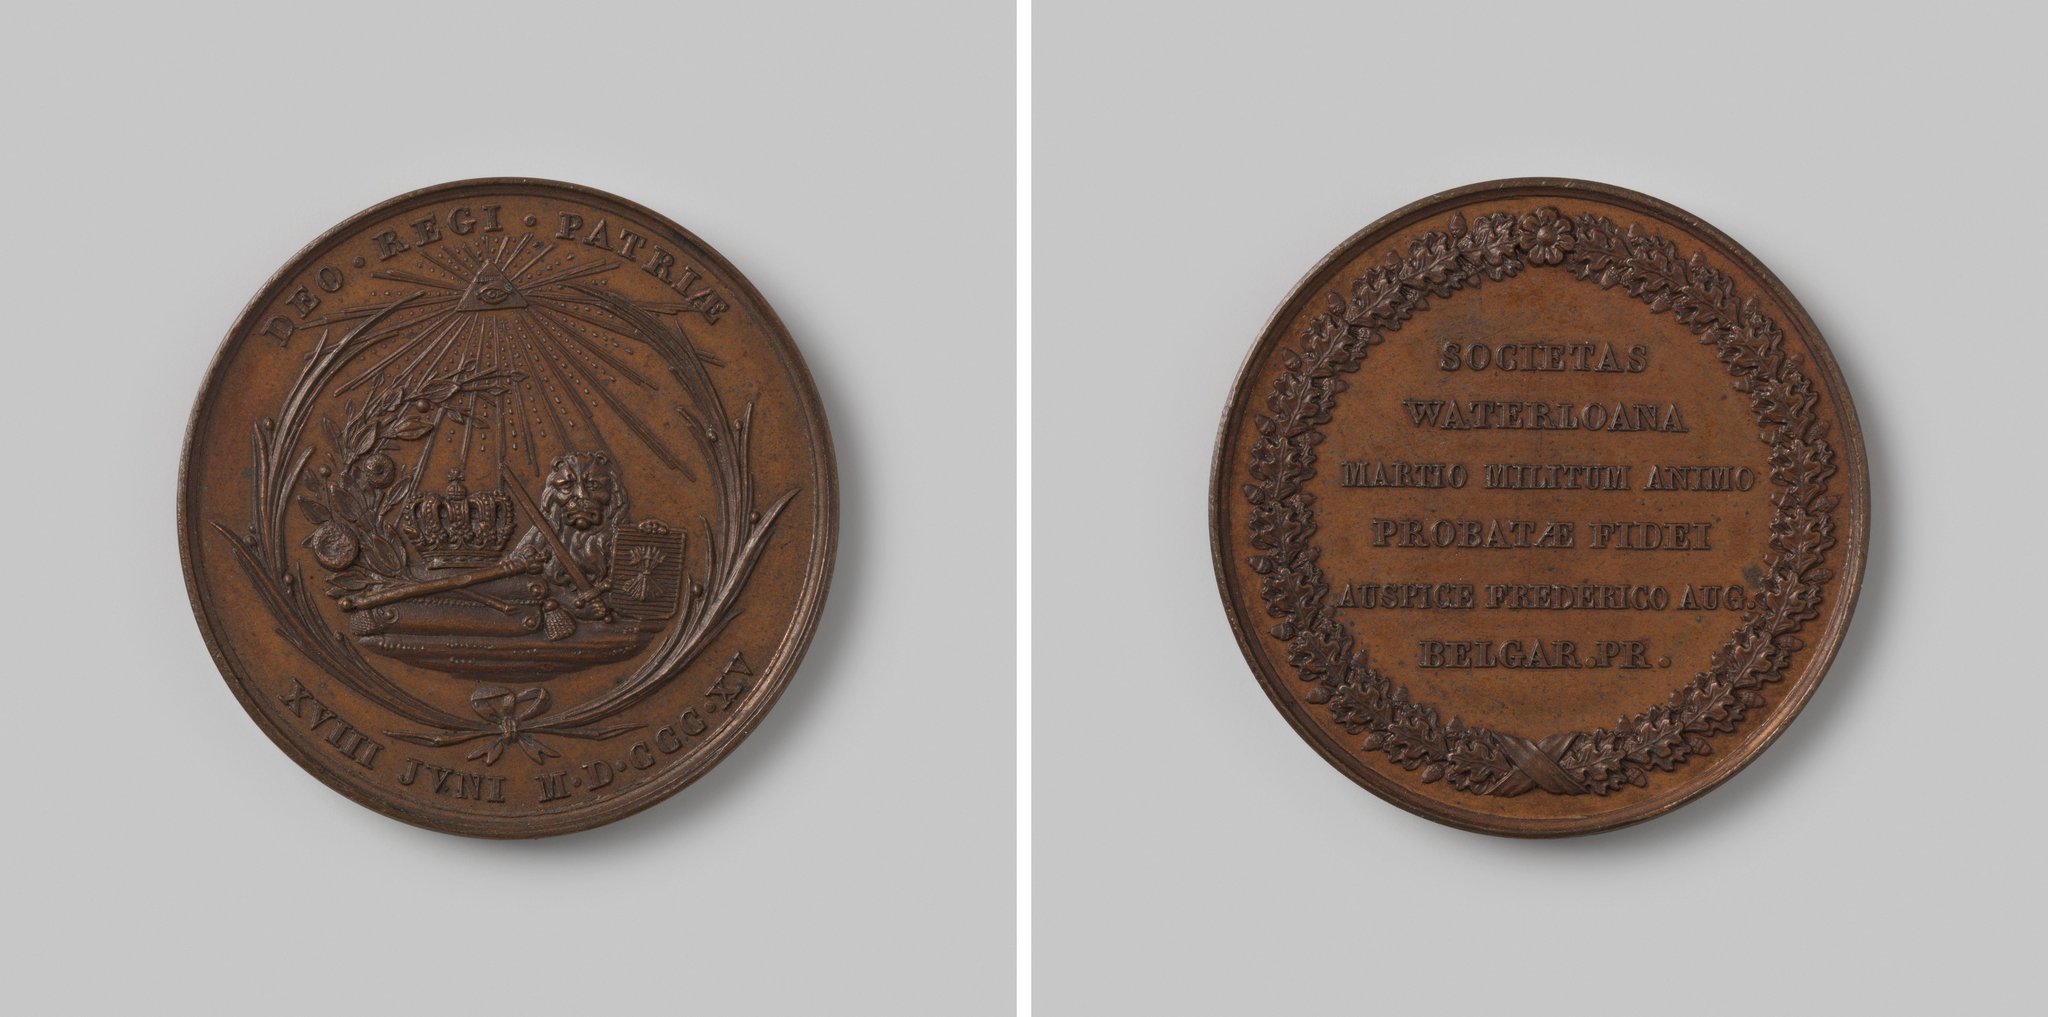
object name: history medal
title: Het Waterloo-gezelschap bij de vijftigjarige herdenking van de Slag bij Waterloo 1865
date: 1865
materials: bronze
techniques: striking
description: Bronzen penning, op de voorzijde een oranjetak, een kussen met kroon en scepter en een leeuw met zwaard en wapenschild met pijlenbundel, onder het stralend oog Gods, tussen samengestrikte palmtakken, met omschrift, op de keerzijde zes regels tekst binnen een eikenkrans.